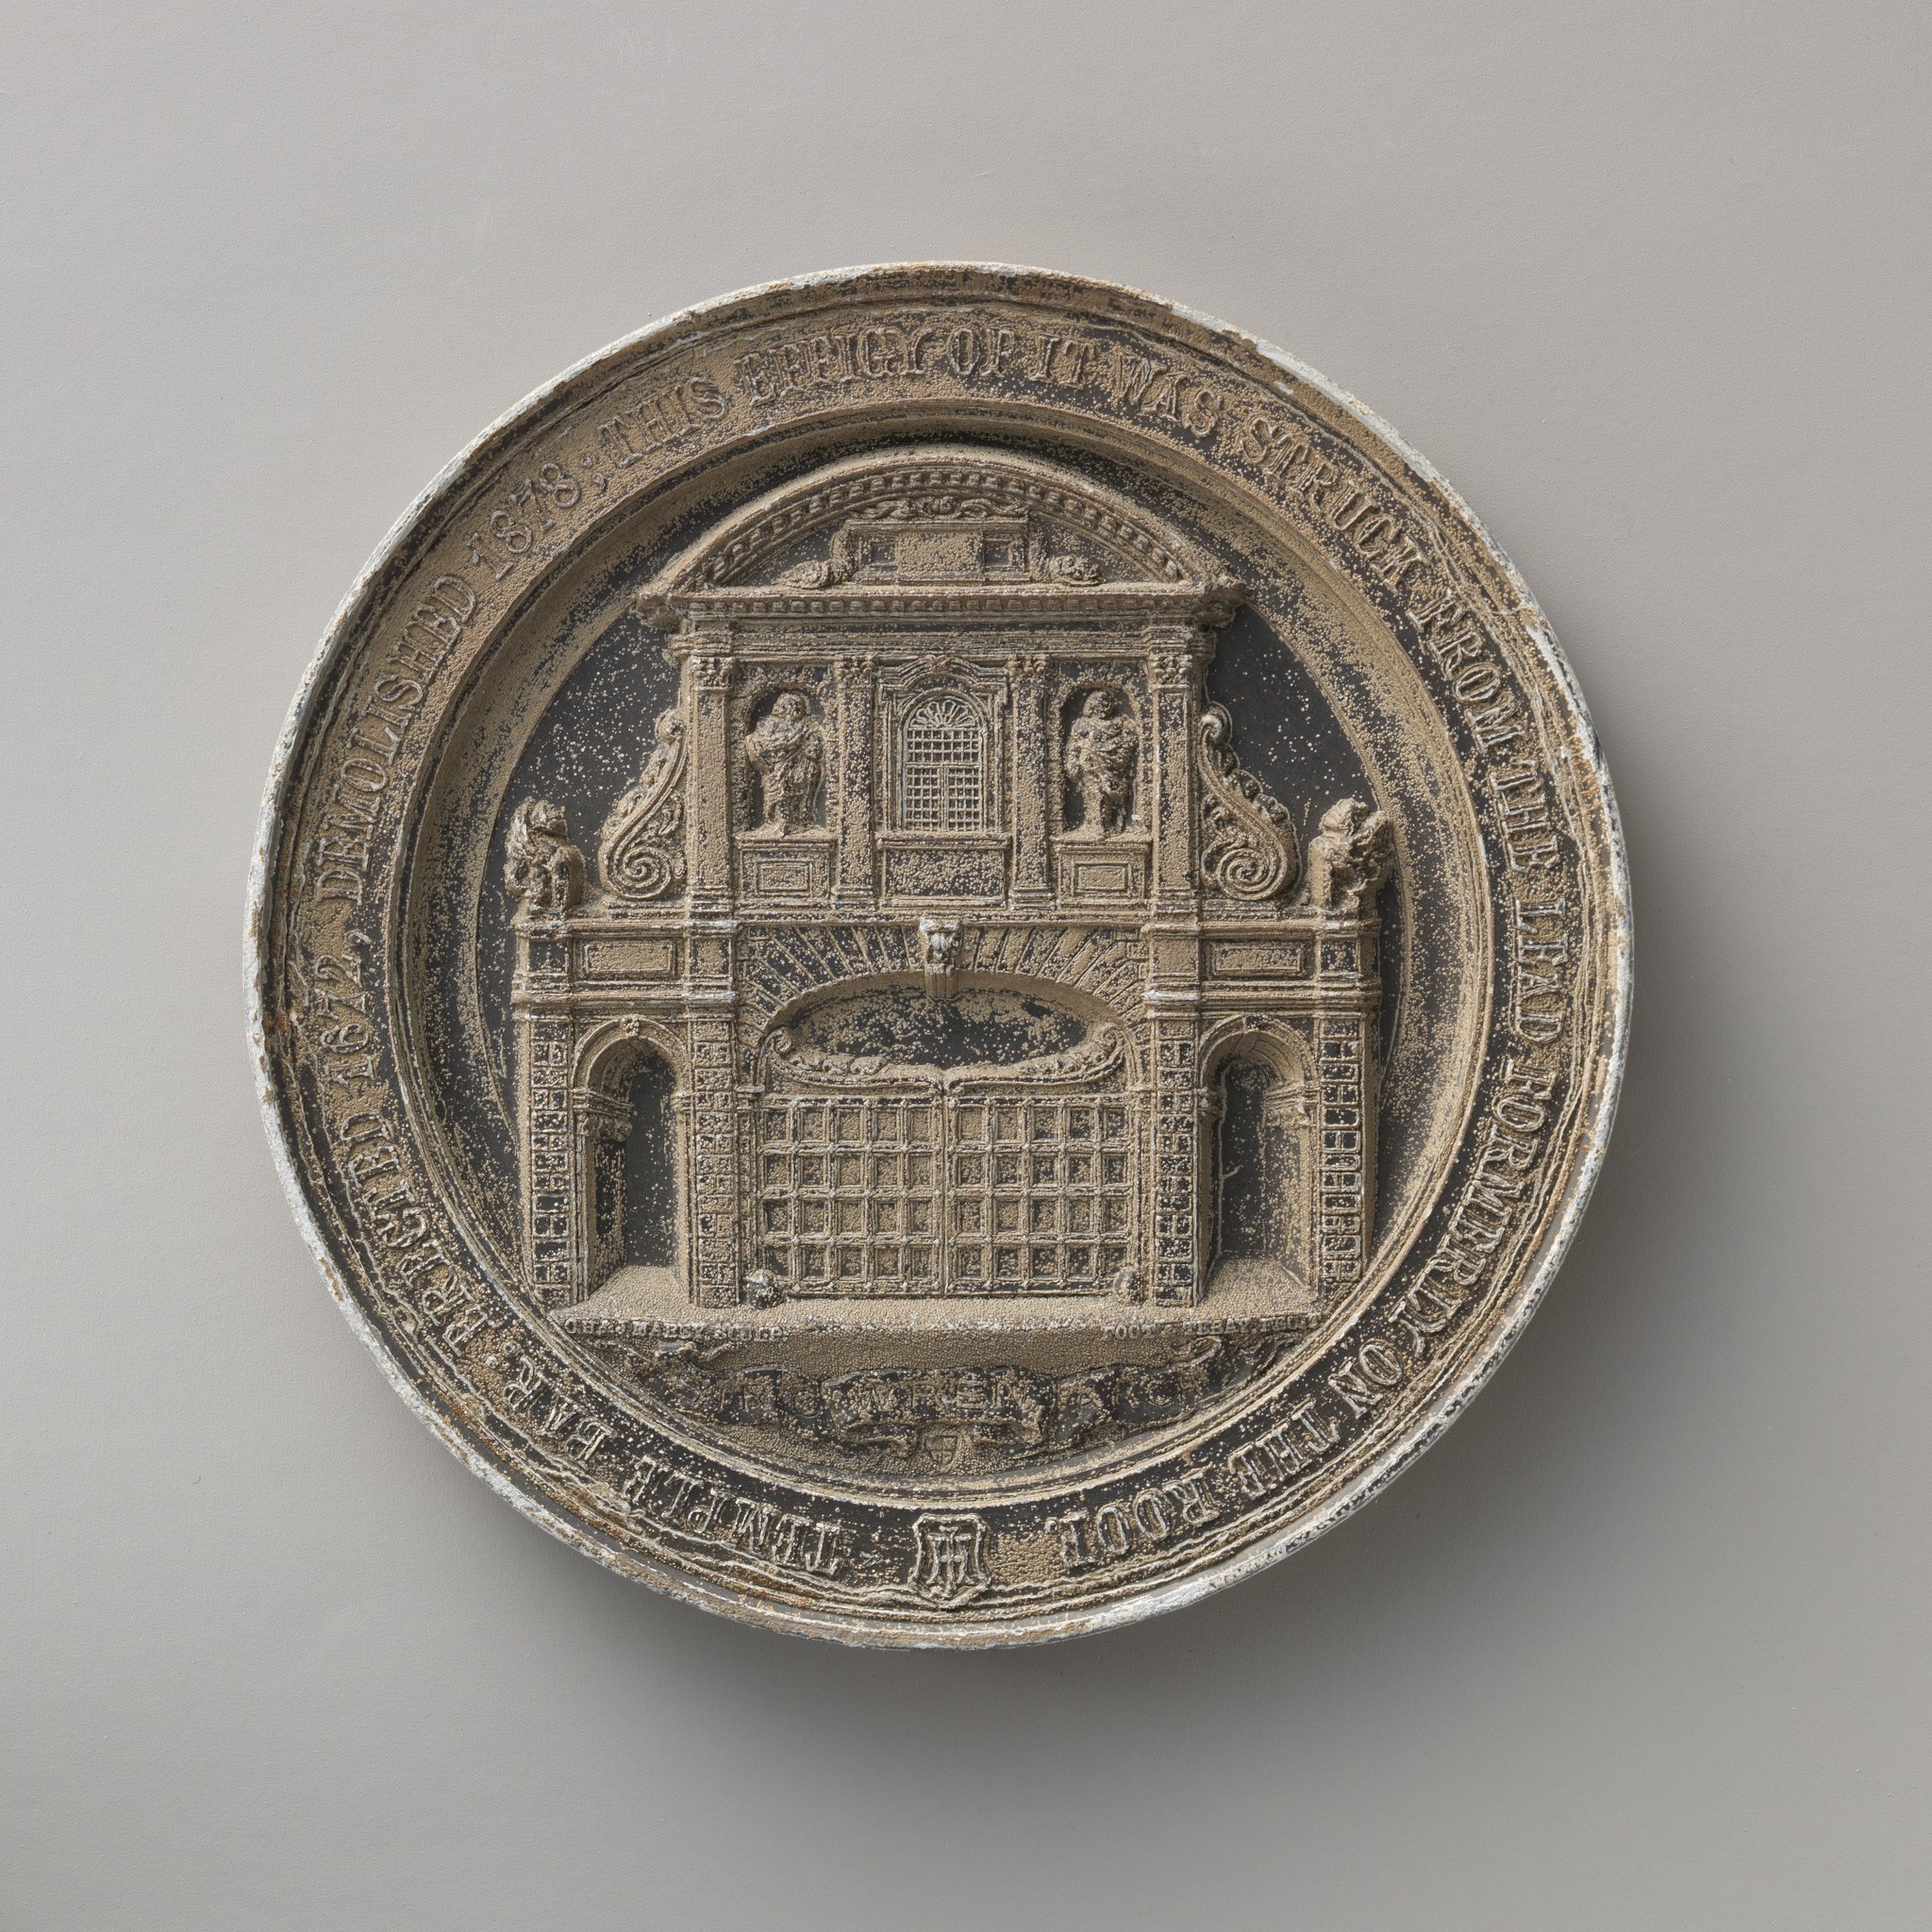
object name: medal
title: Memorial of the old Temple Bar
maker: c. h. mabey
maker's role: artist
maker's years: 1825-1925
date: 1878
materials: lead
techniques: struck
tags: temples